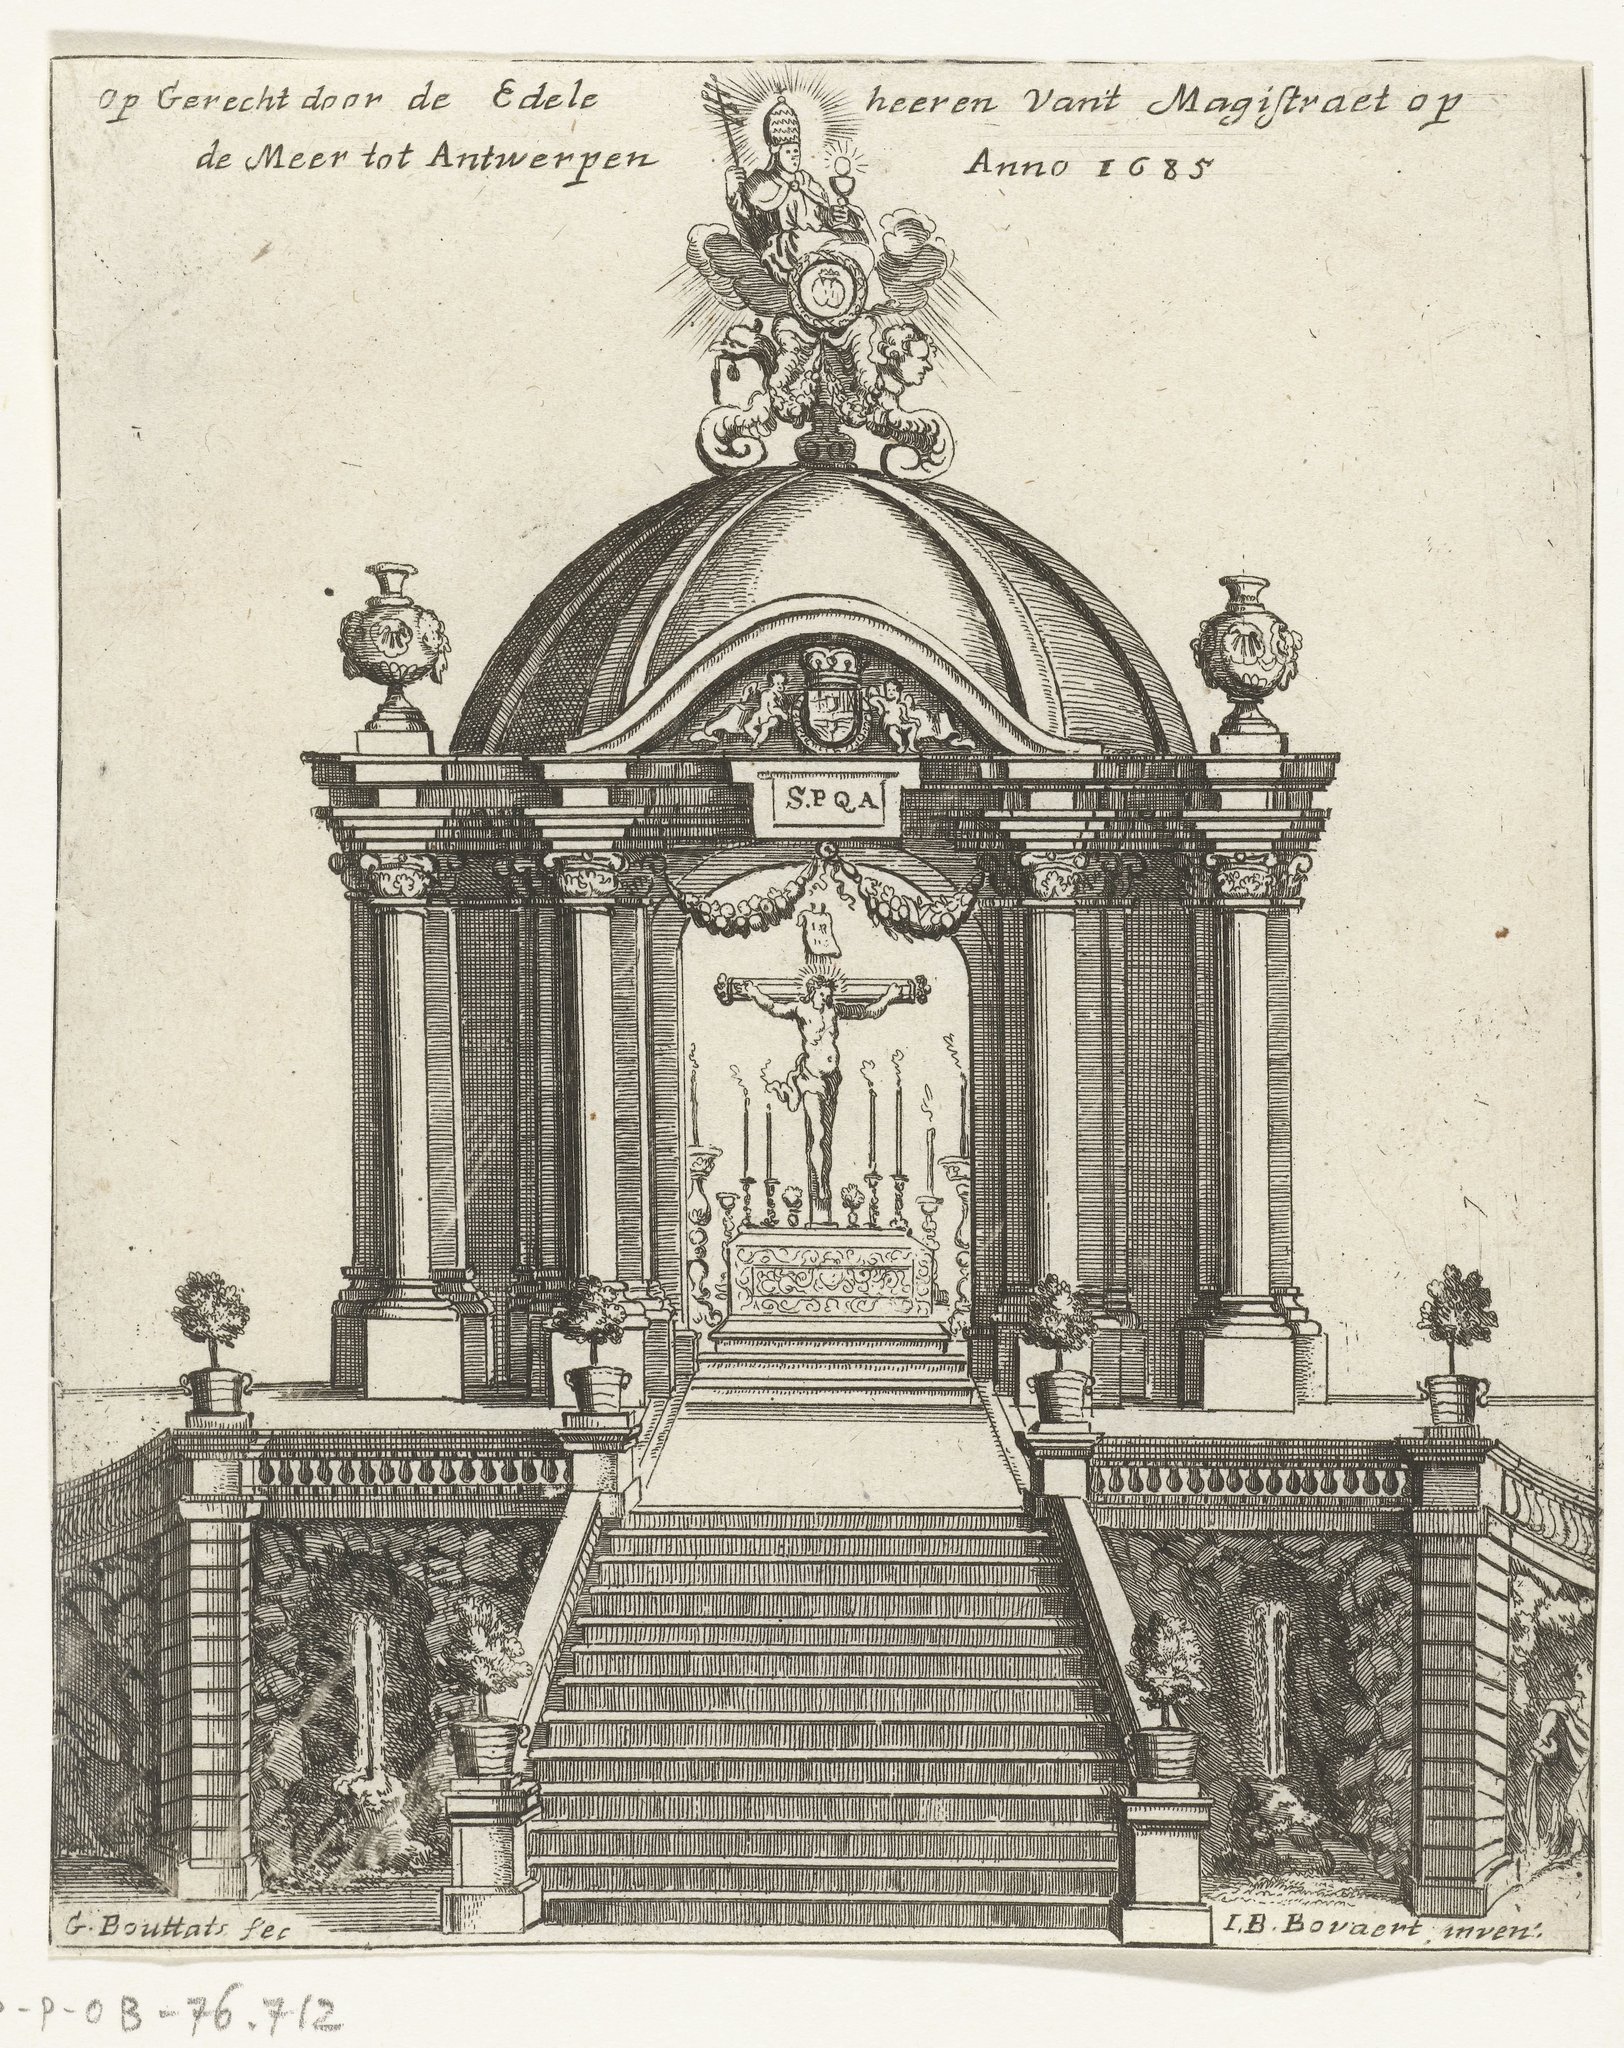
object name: print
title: Altaar in de vorm van een tempietto opgericht magistraten op de Meir, 1685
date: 1685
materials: paper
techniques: etching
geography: southern netherlands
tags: other decorative structures (~ triumphal entry, etc.), antwerp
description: Gebruikt als illustratie in: Hondert-jaerigh jubile-vreught bewesen in dese stadt Antwerpen ter oorsaecke vande herstellinge des geloofs in't jaer 1585. door de glorieuse waepenen van sijne catholijcke majesteyt, onder t'beleyt van ... Alexander Farnesius ... / Ghemaeckt ende by-een vergadert door ... Petrus Franciscus de Smidt, Hieronymus Verdussen den jonghere, Antwerpen 1685.